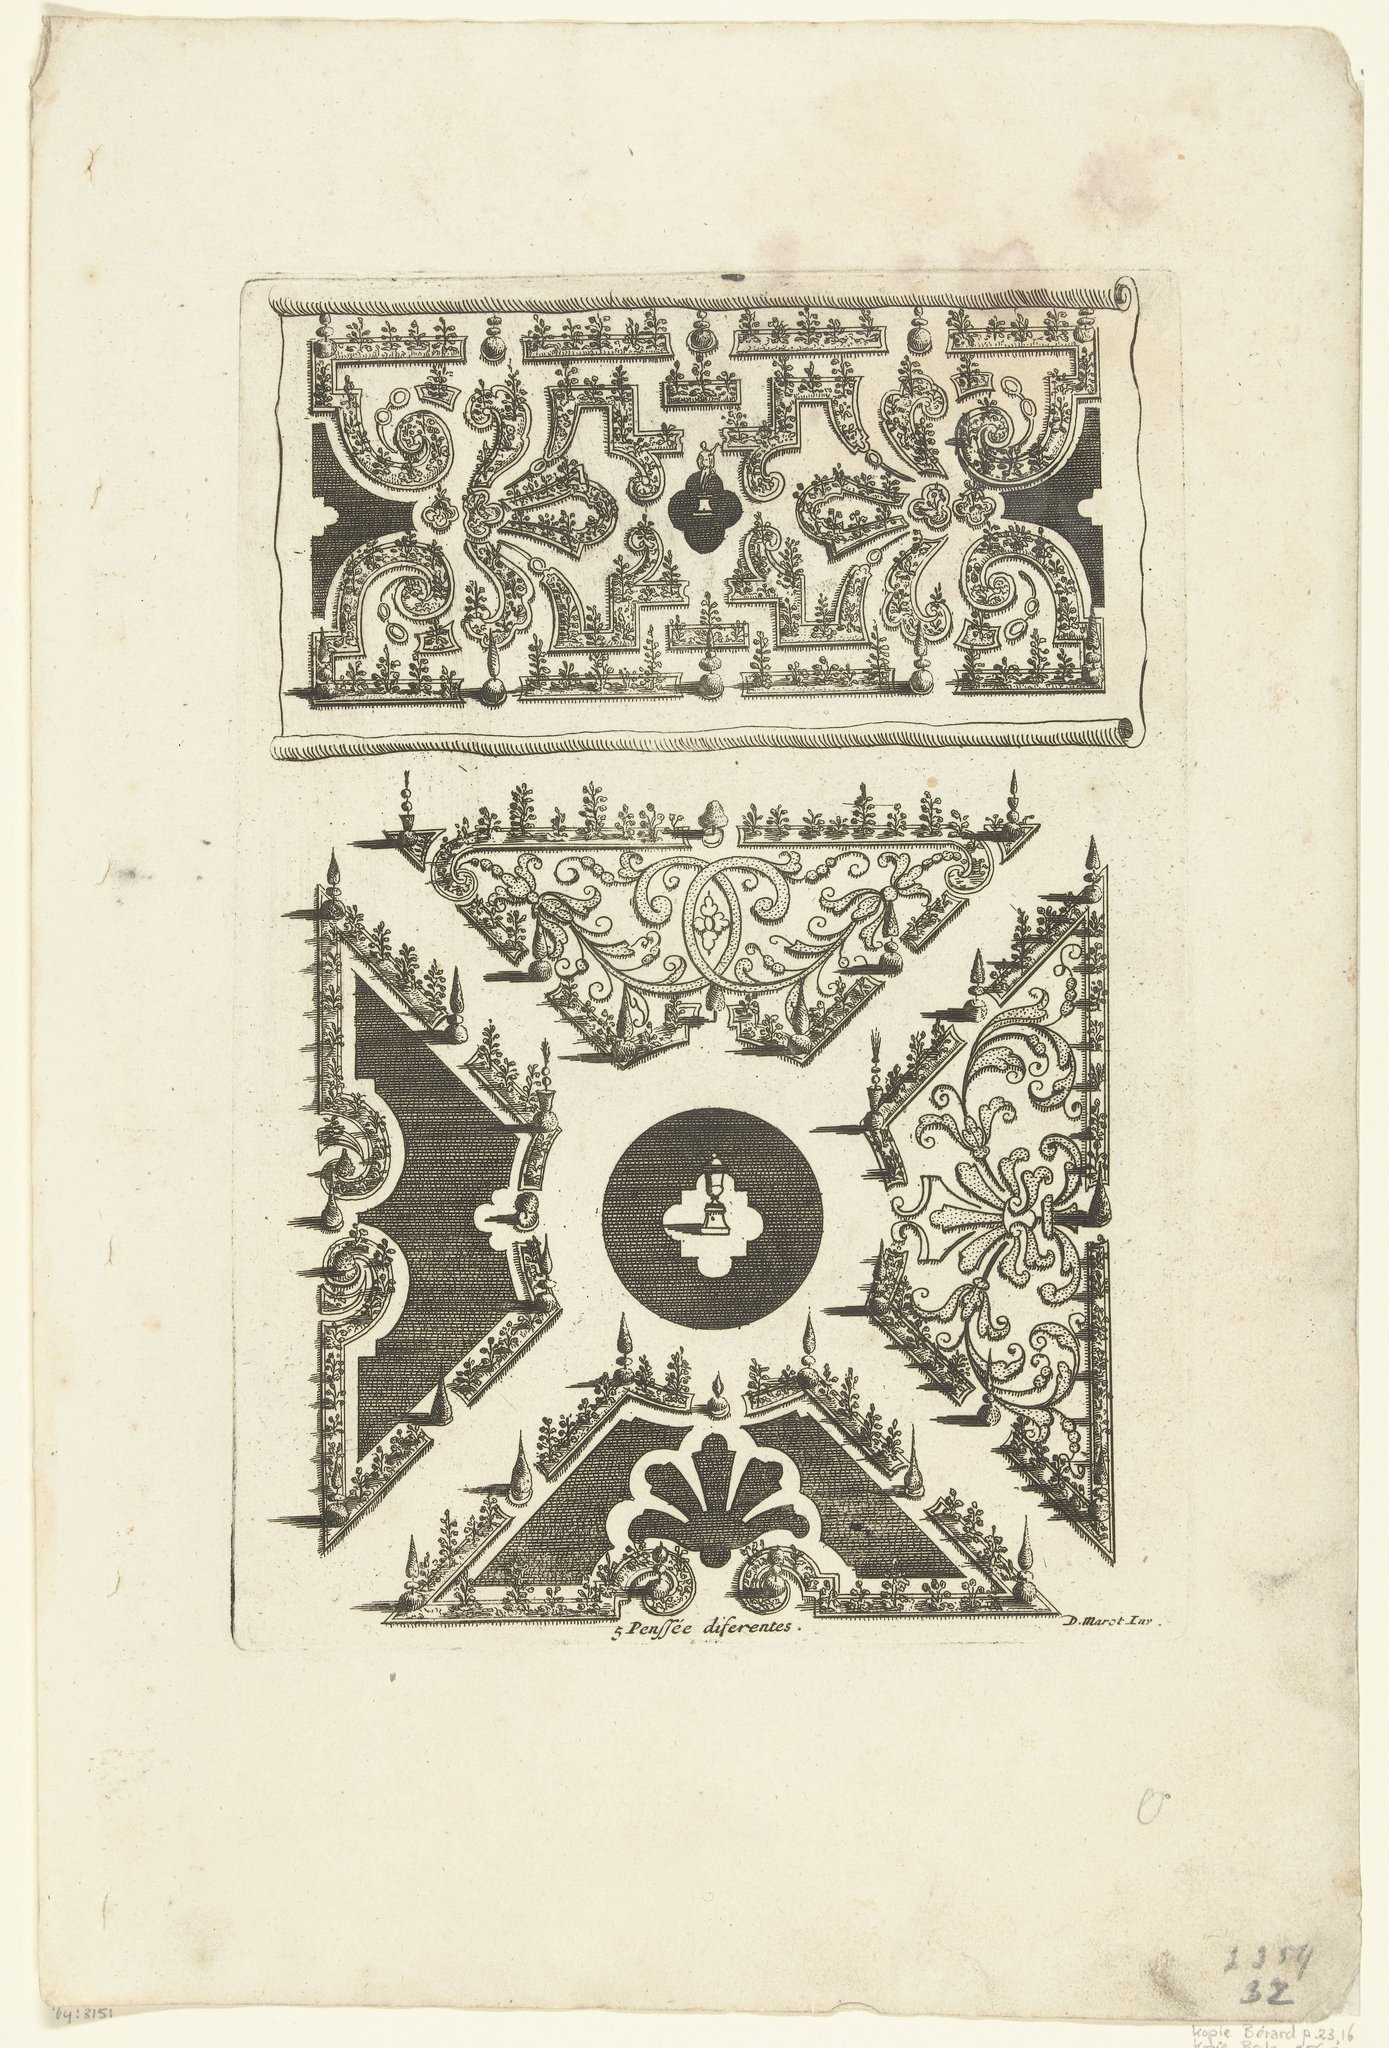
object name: ornament print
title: Penssée diferentes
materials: paper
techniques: etching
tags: lay-out of garden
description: Onderaan staat een plan voor een tuin met een alternatief ontwerp voor vier parterres; bovenaan staat een plan voor een tuin met rabatten met bloemen. Tegenzijdige kopie naar prent uit serie Nouveux Livre de Parterres uitgegeven door Daniel Marot. Blad uit serie tuinontwerpen met parterres, fonteinen en paviljoenen met latwerk.